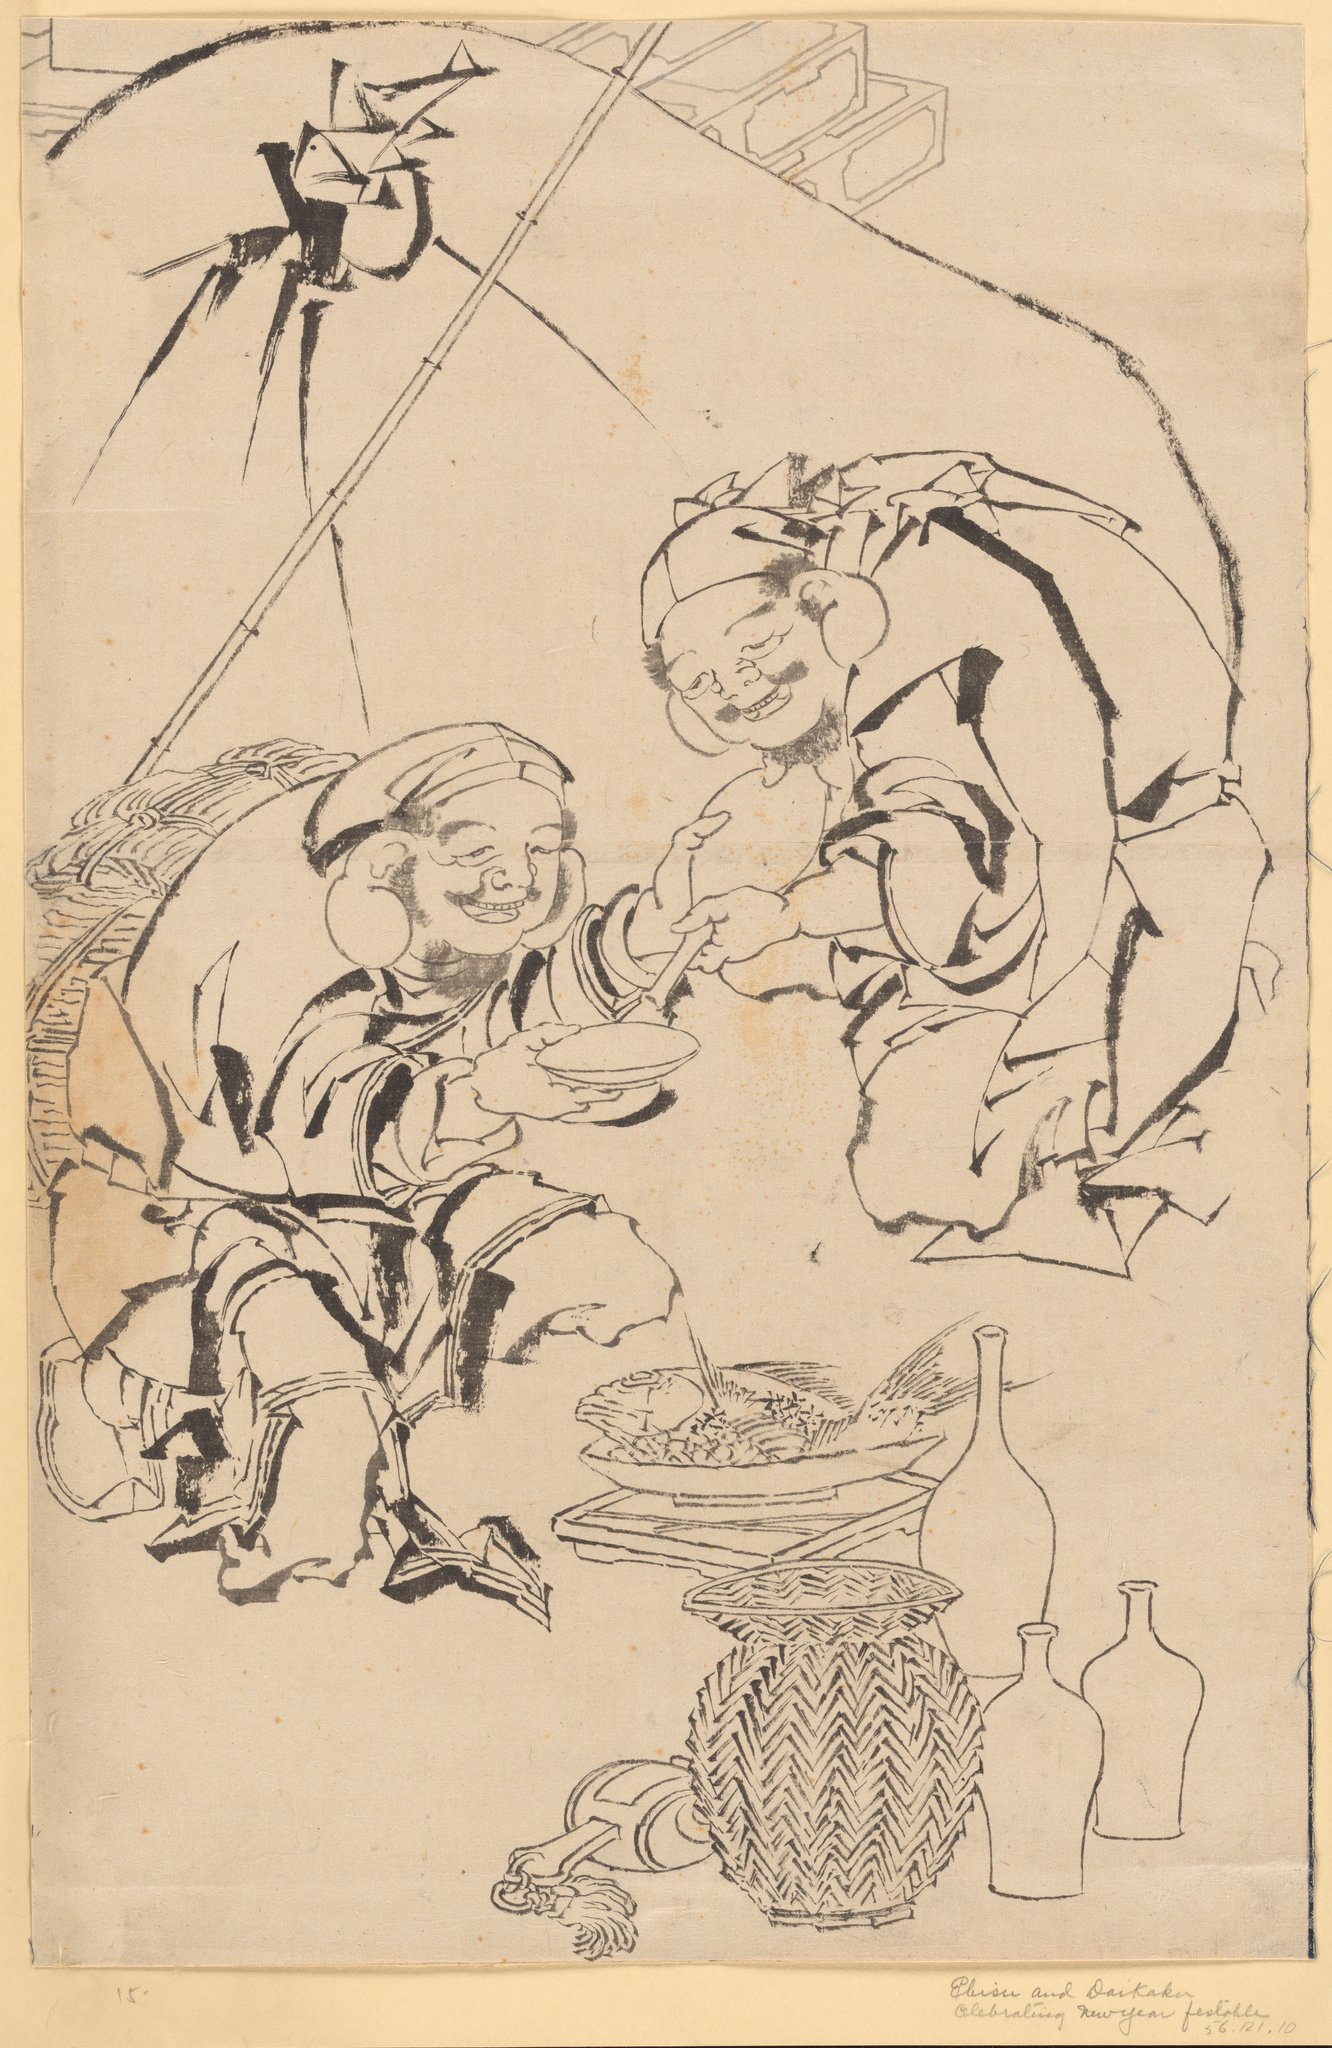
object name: drawing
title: Ebisu and Daikoku Celebrating the New Year Festival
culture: japanese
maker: katsushika hokusai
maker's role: artist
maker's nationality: japanese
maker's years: 1760-1849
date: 1701-1900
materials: ink, paper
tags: food,men,fish